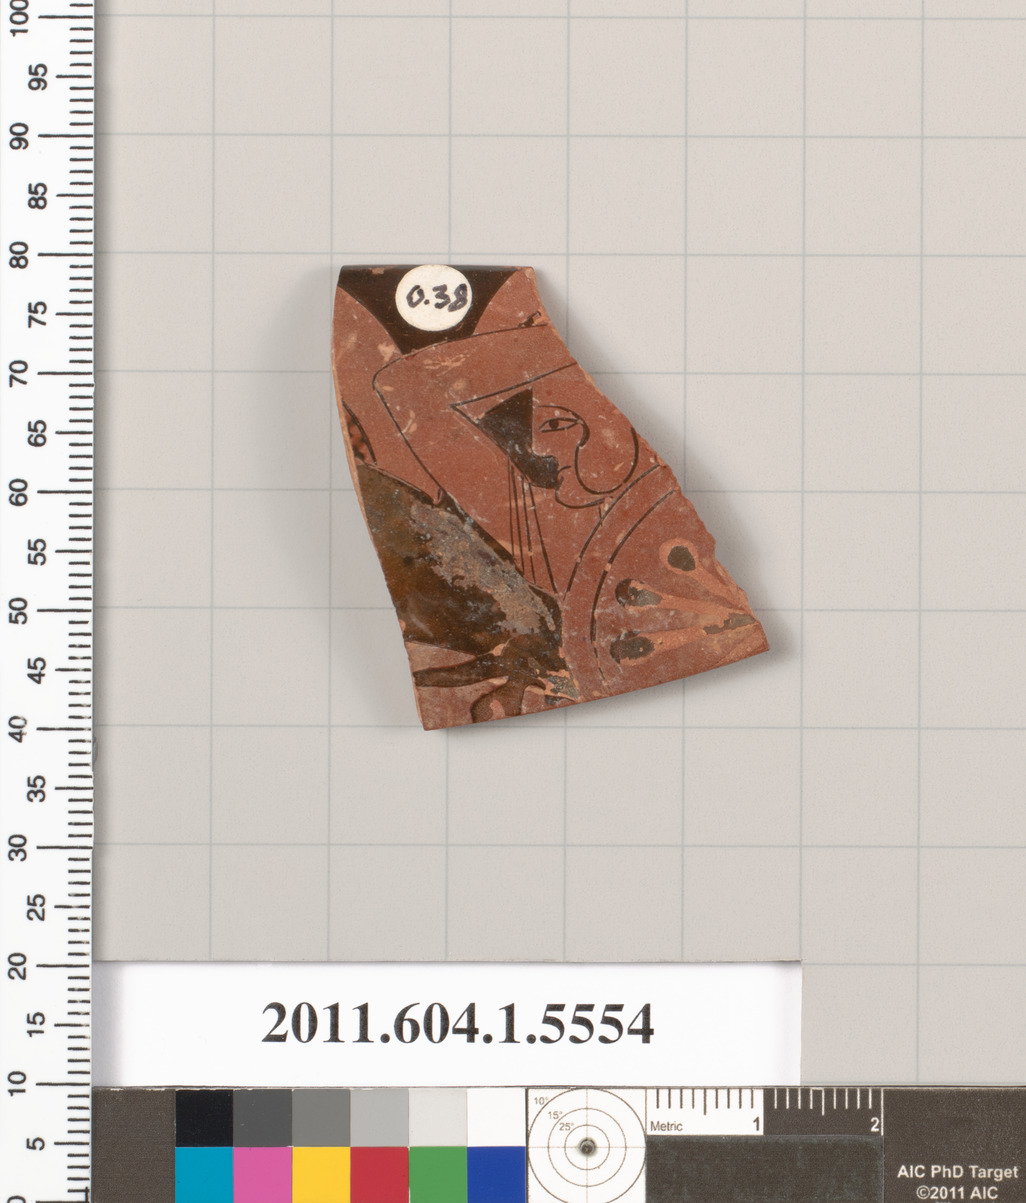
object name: kylix fragment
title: Terracotta rim fragment of a kylix (drinking cup)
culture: greek, attic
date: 510-490 BCE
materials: terracotta